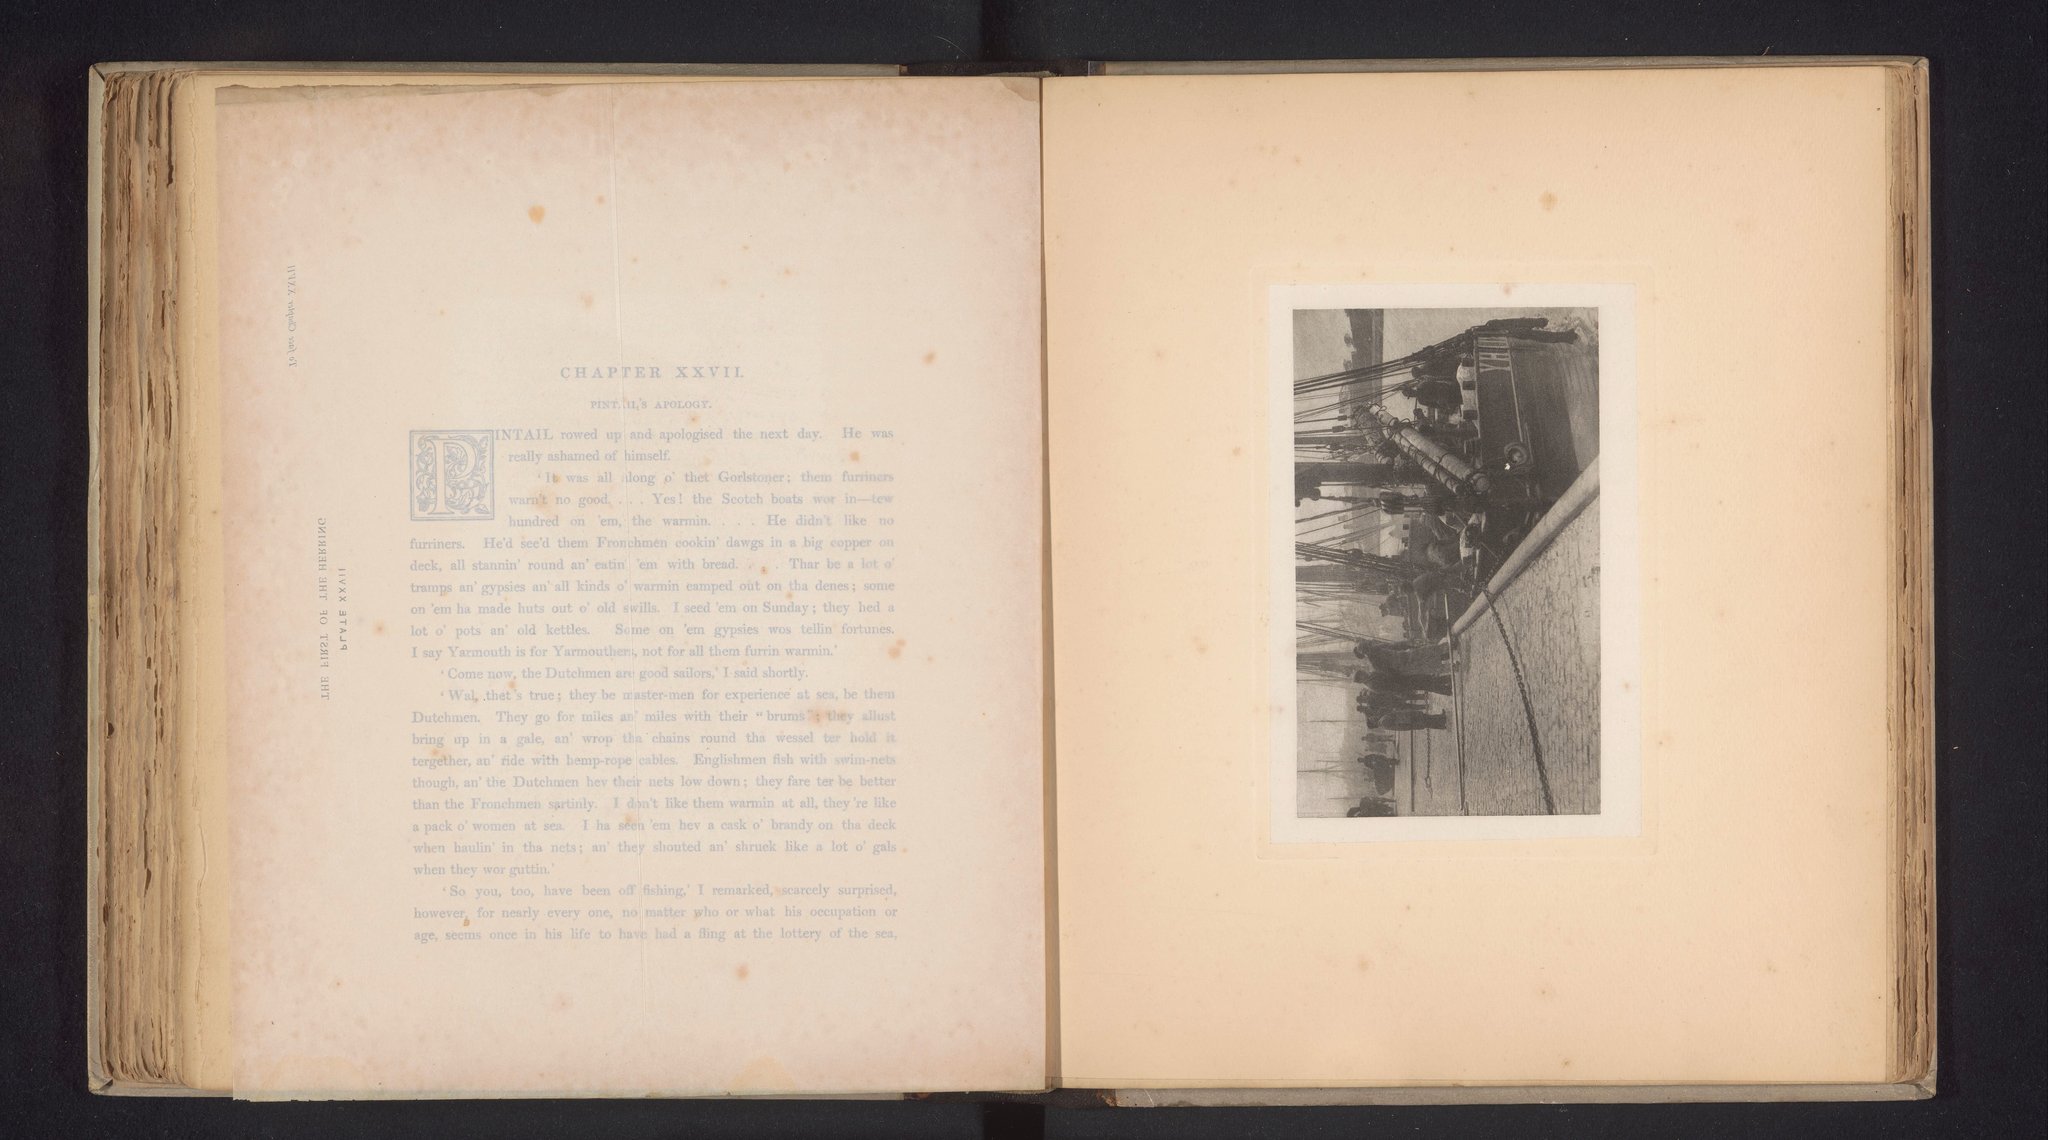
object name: page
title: Haringschip in de haven van Great Yarmouth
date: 1880-1890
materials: paper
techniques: photoaquatint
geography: great yarmouth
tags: harbour, ships (in general)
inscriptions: number: ‘Plate XXVII’, inscription: ‘The first of the herring’